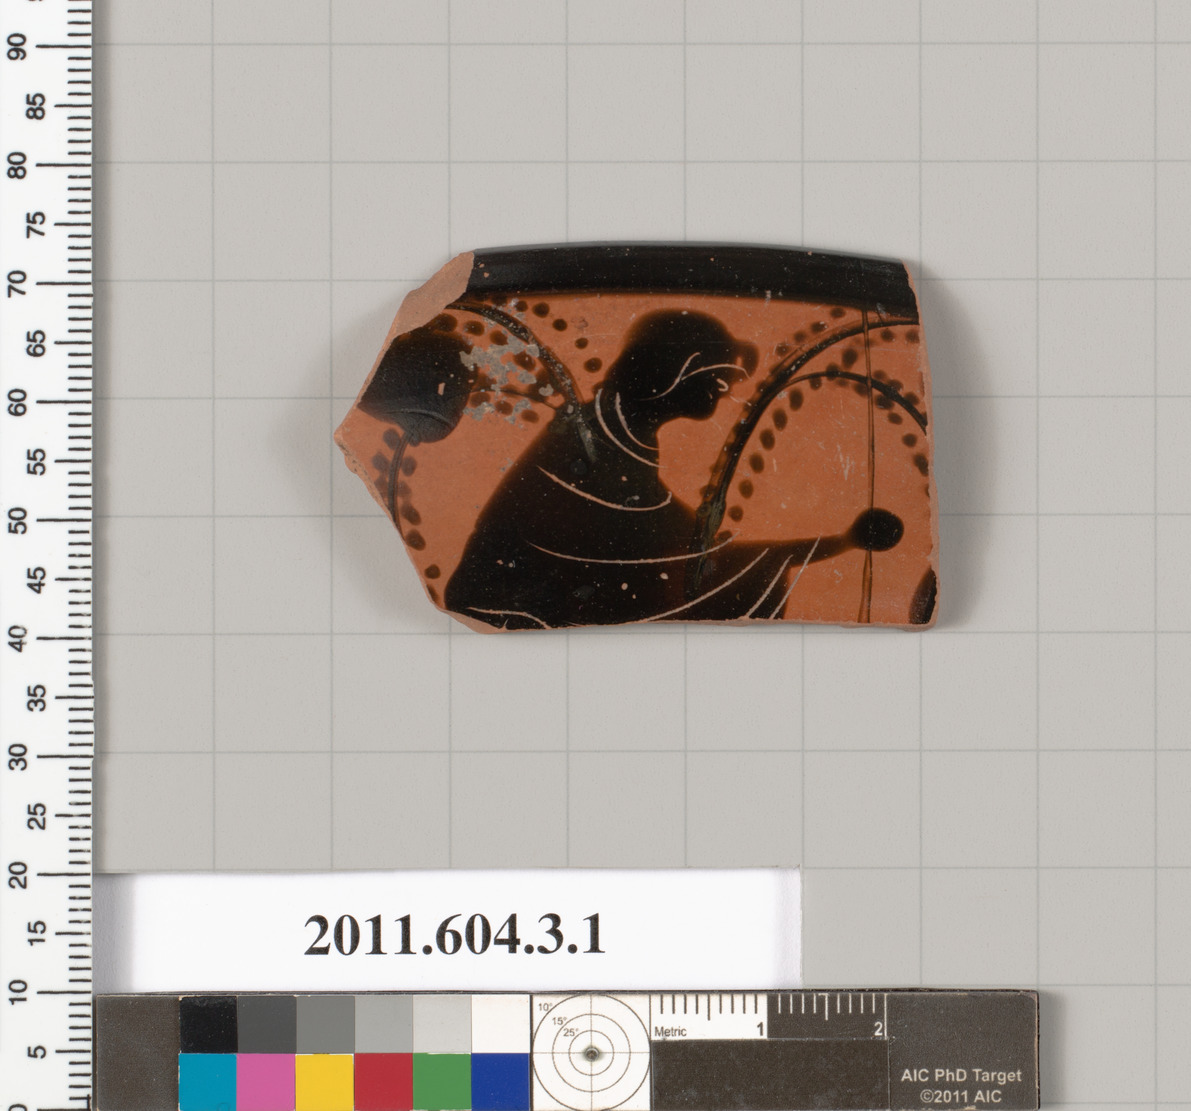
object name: skyphos fragment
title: Terracotta rim fragment of a skyphos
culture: greek, attic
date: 490-480 BCE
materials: terracotta